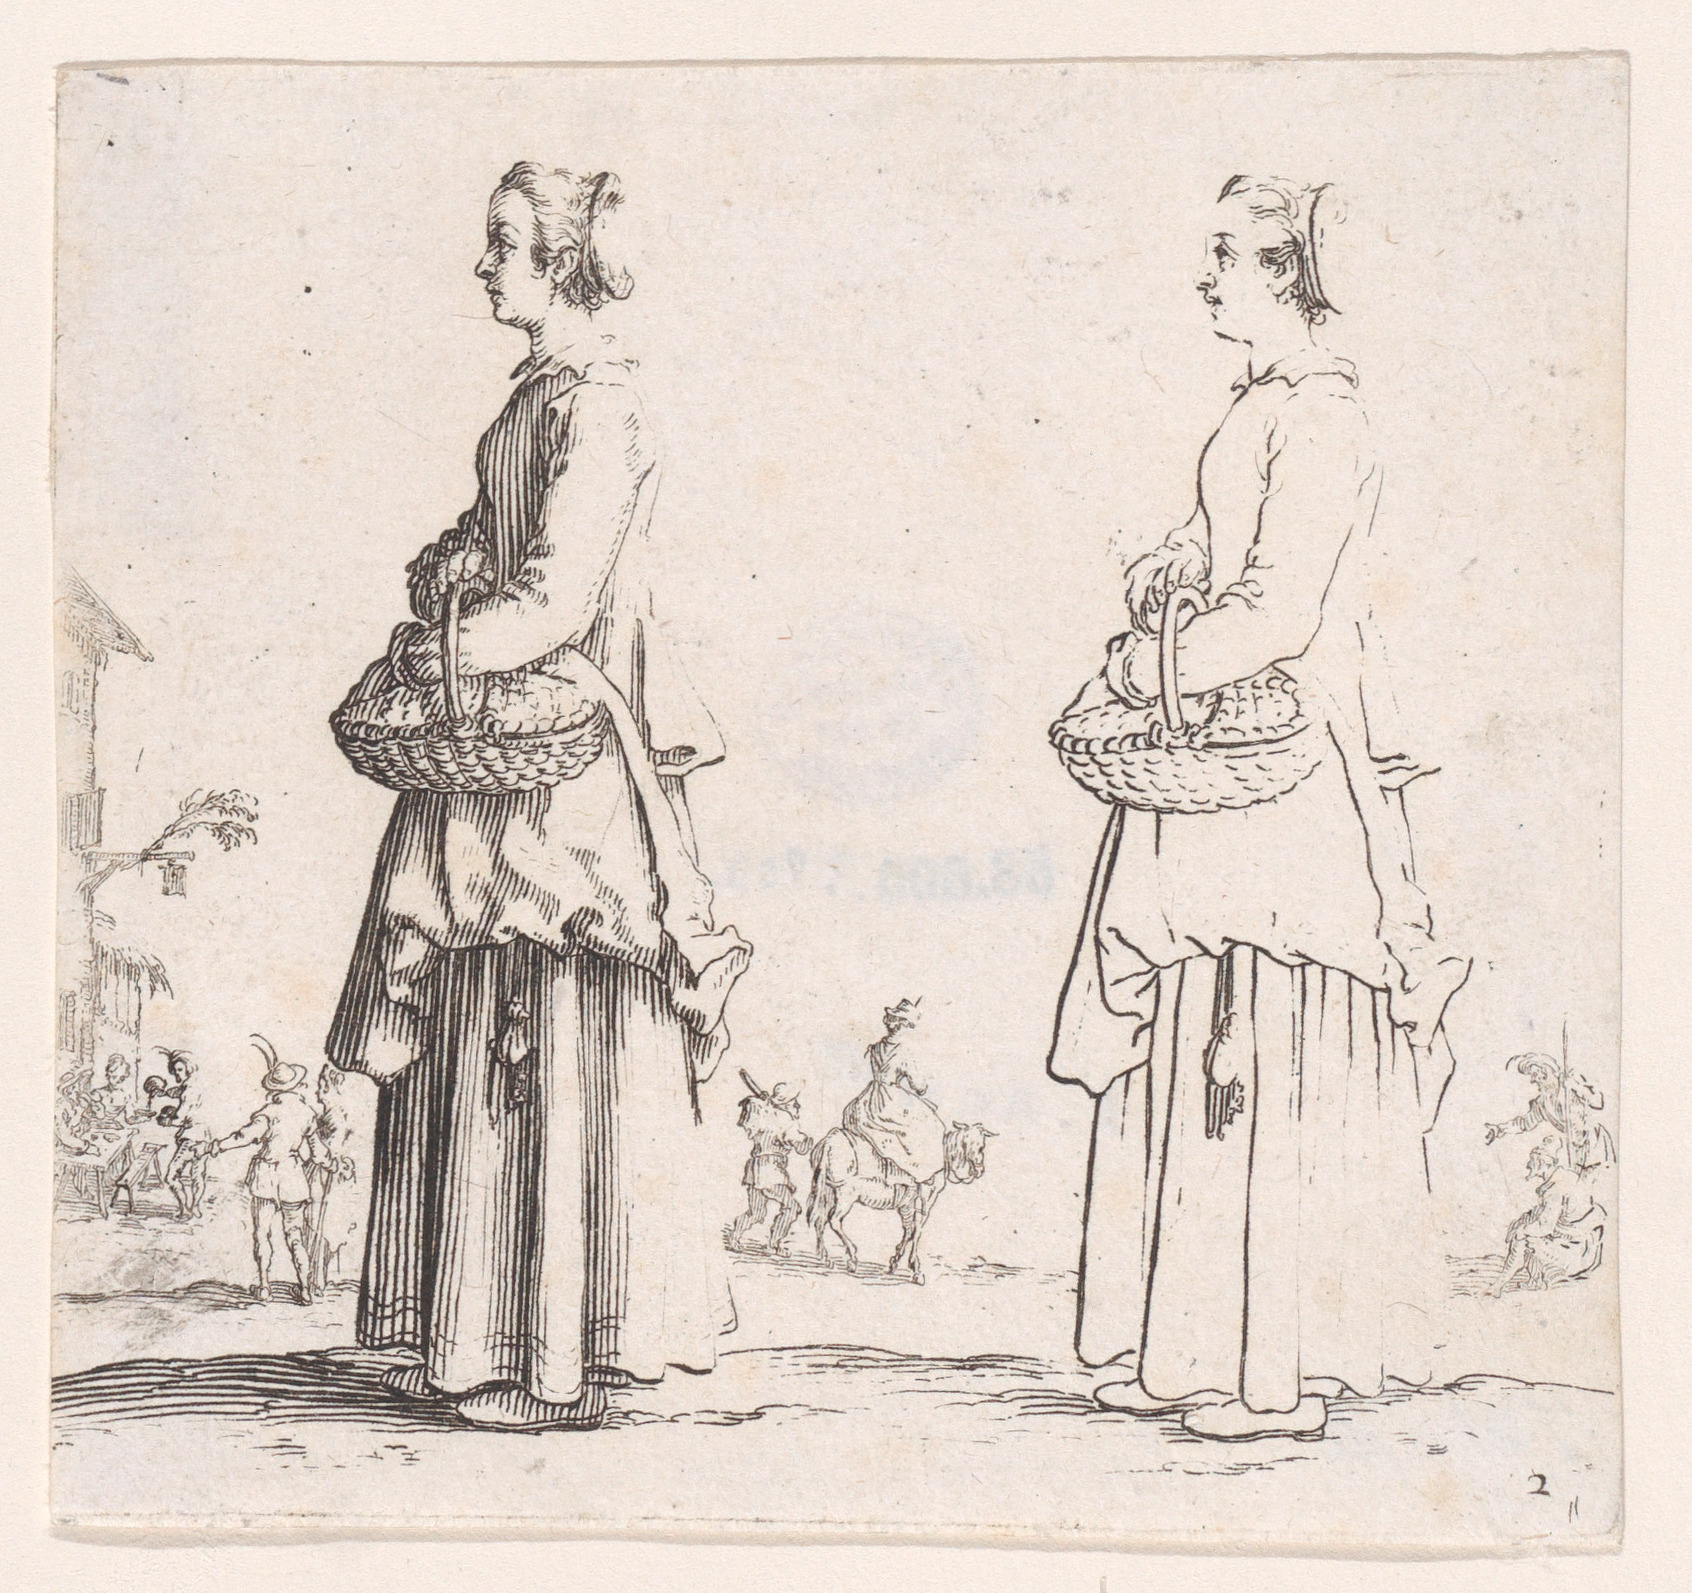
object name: print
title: La Paysanne Tournée a Gauche, un Panier a son Bras (La Paysanne Turned to the Left, a Basket in her Arms), plate 2 from "Varie Figure" (Various Figures)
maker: jacques callot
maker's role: artist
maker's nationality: french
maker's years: 1592-1635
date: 1620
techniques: etching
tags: women,baskets